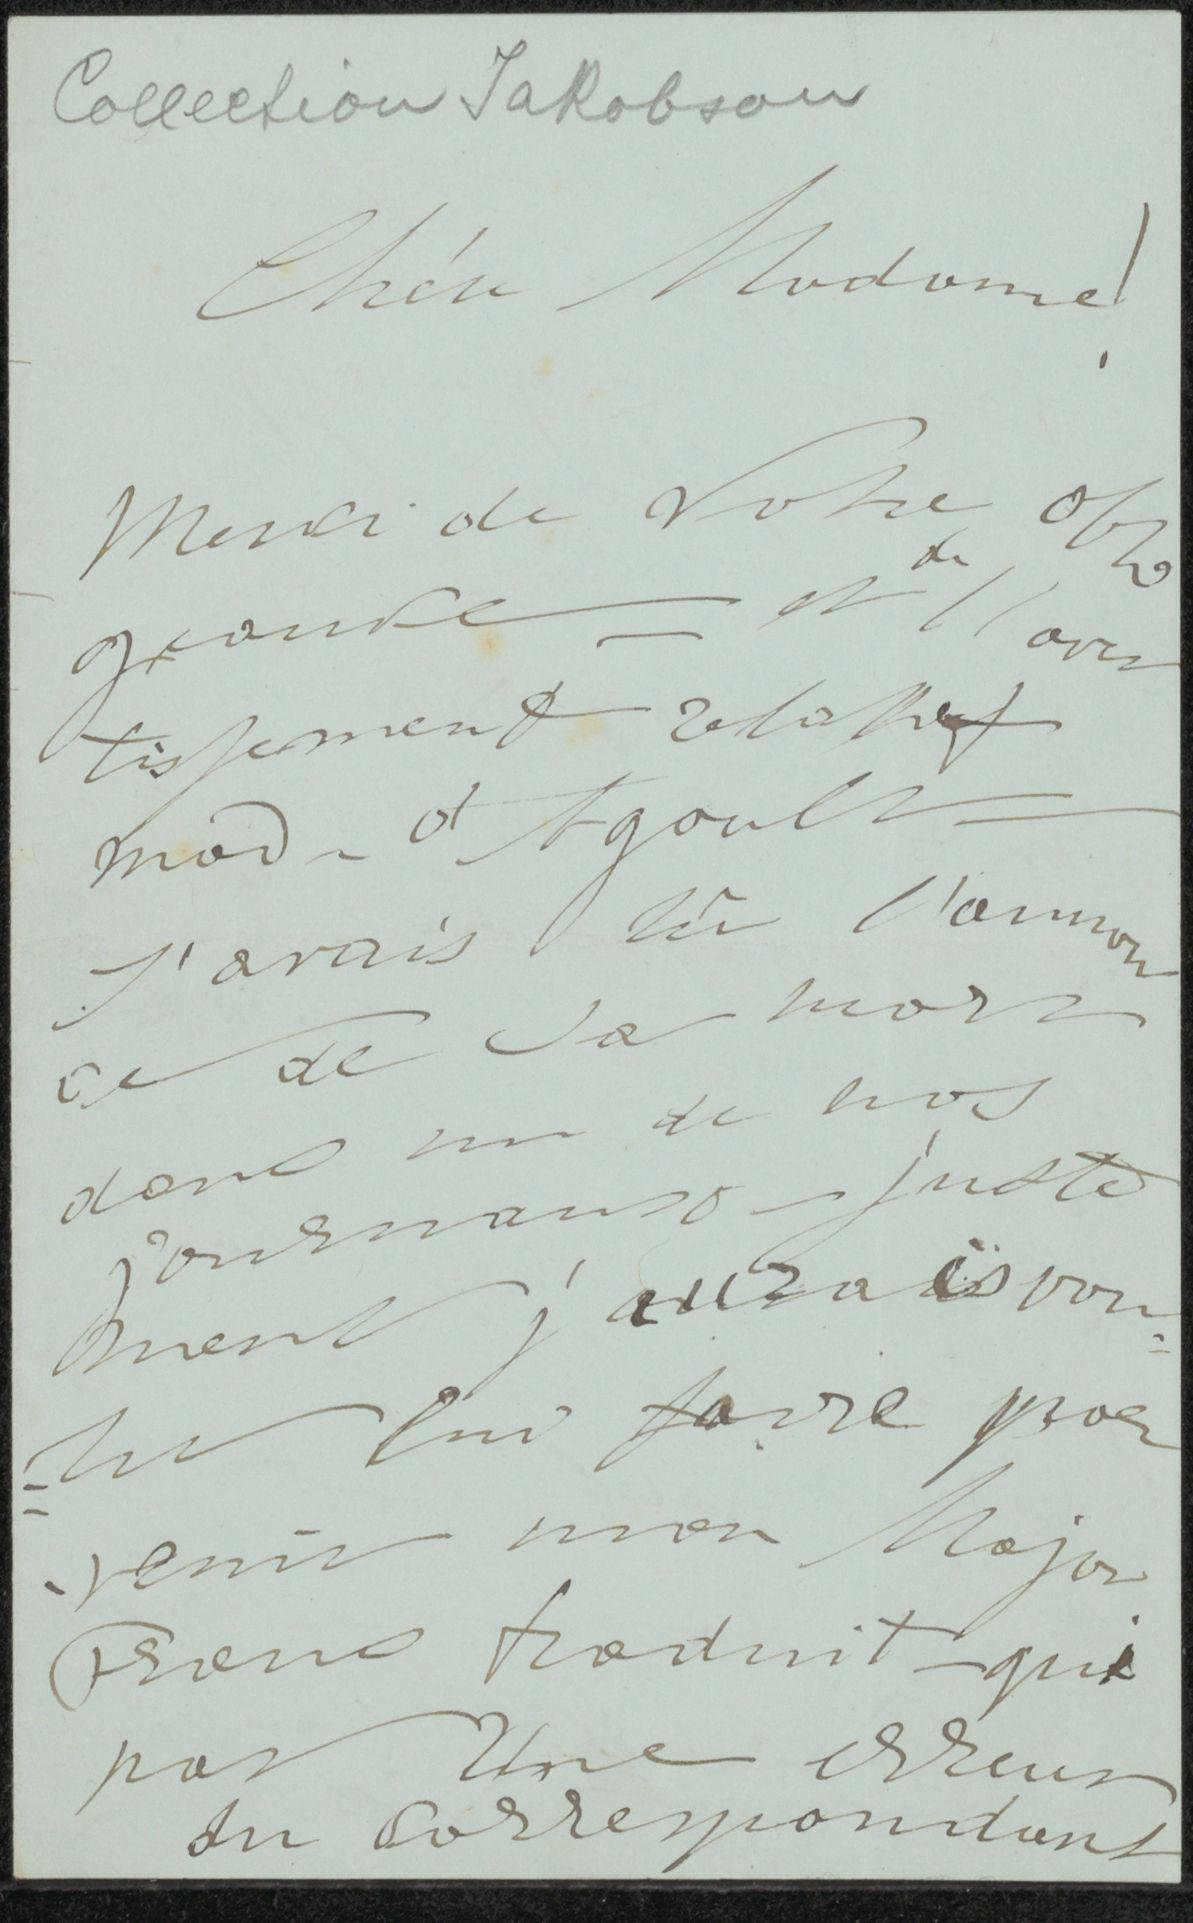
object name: letter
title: Brief aan anoniem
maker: anna louisa geertruyda bosboom-toussaint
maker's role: schrijver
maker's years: 1812-1886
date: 1803-1876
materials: ink, paper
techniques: pen, writing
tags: paris